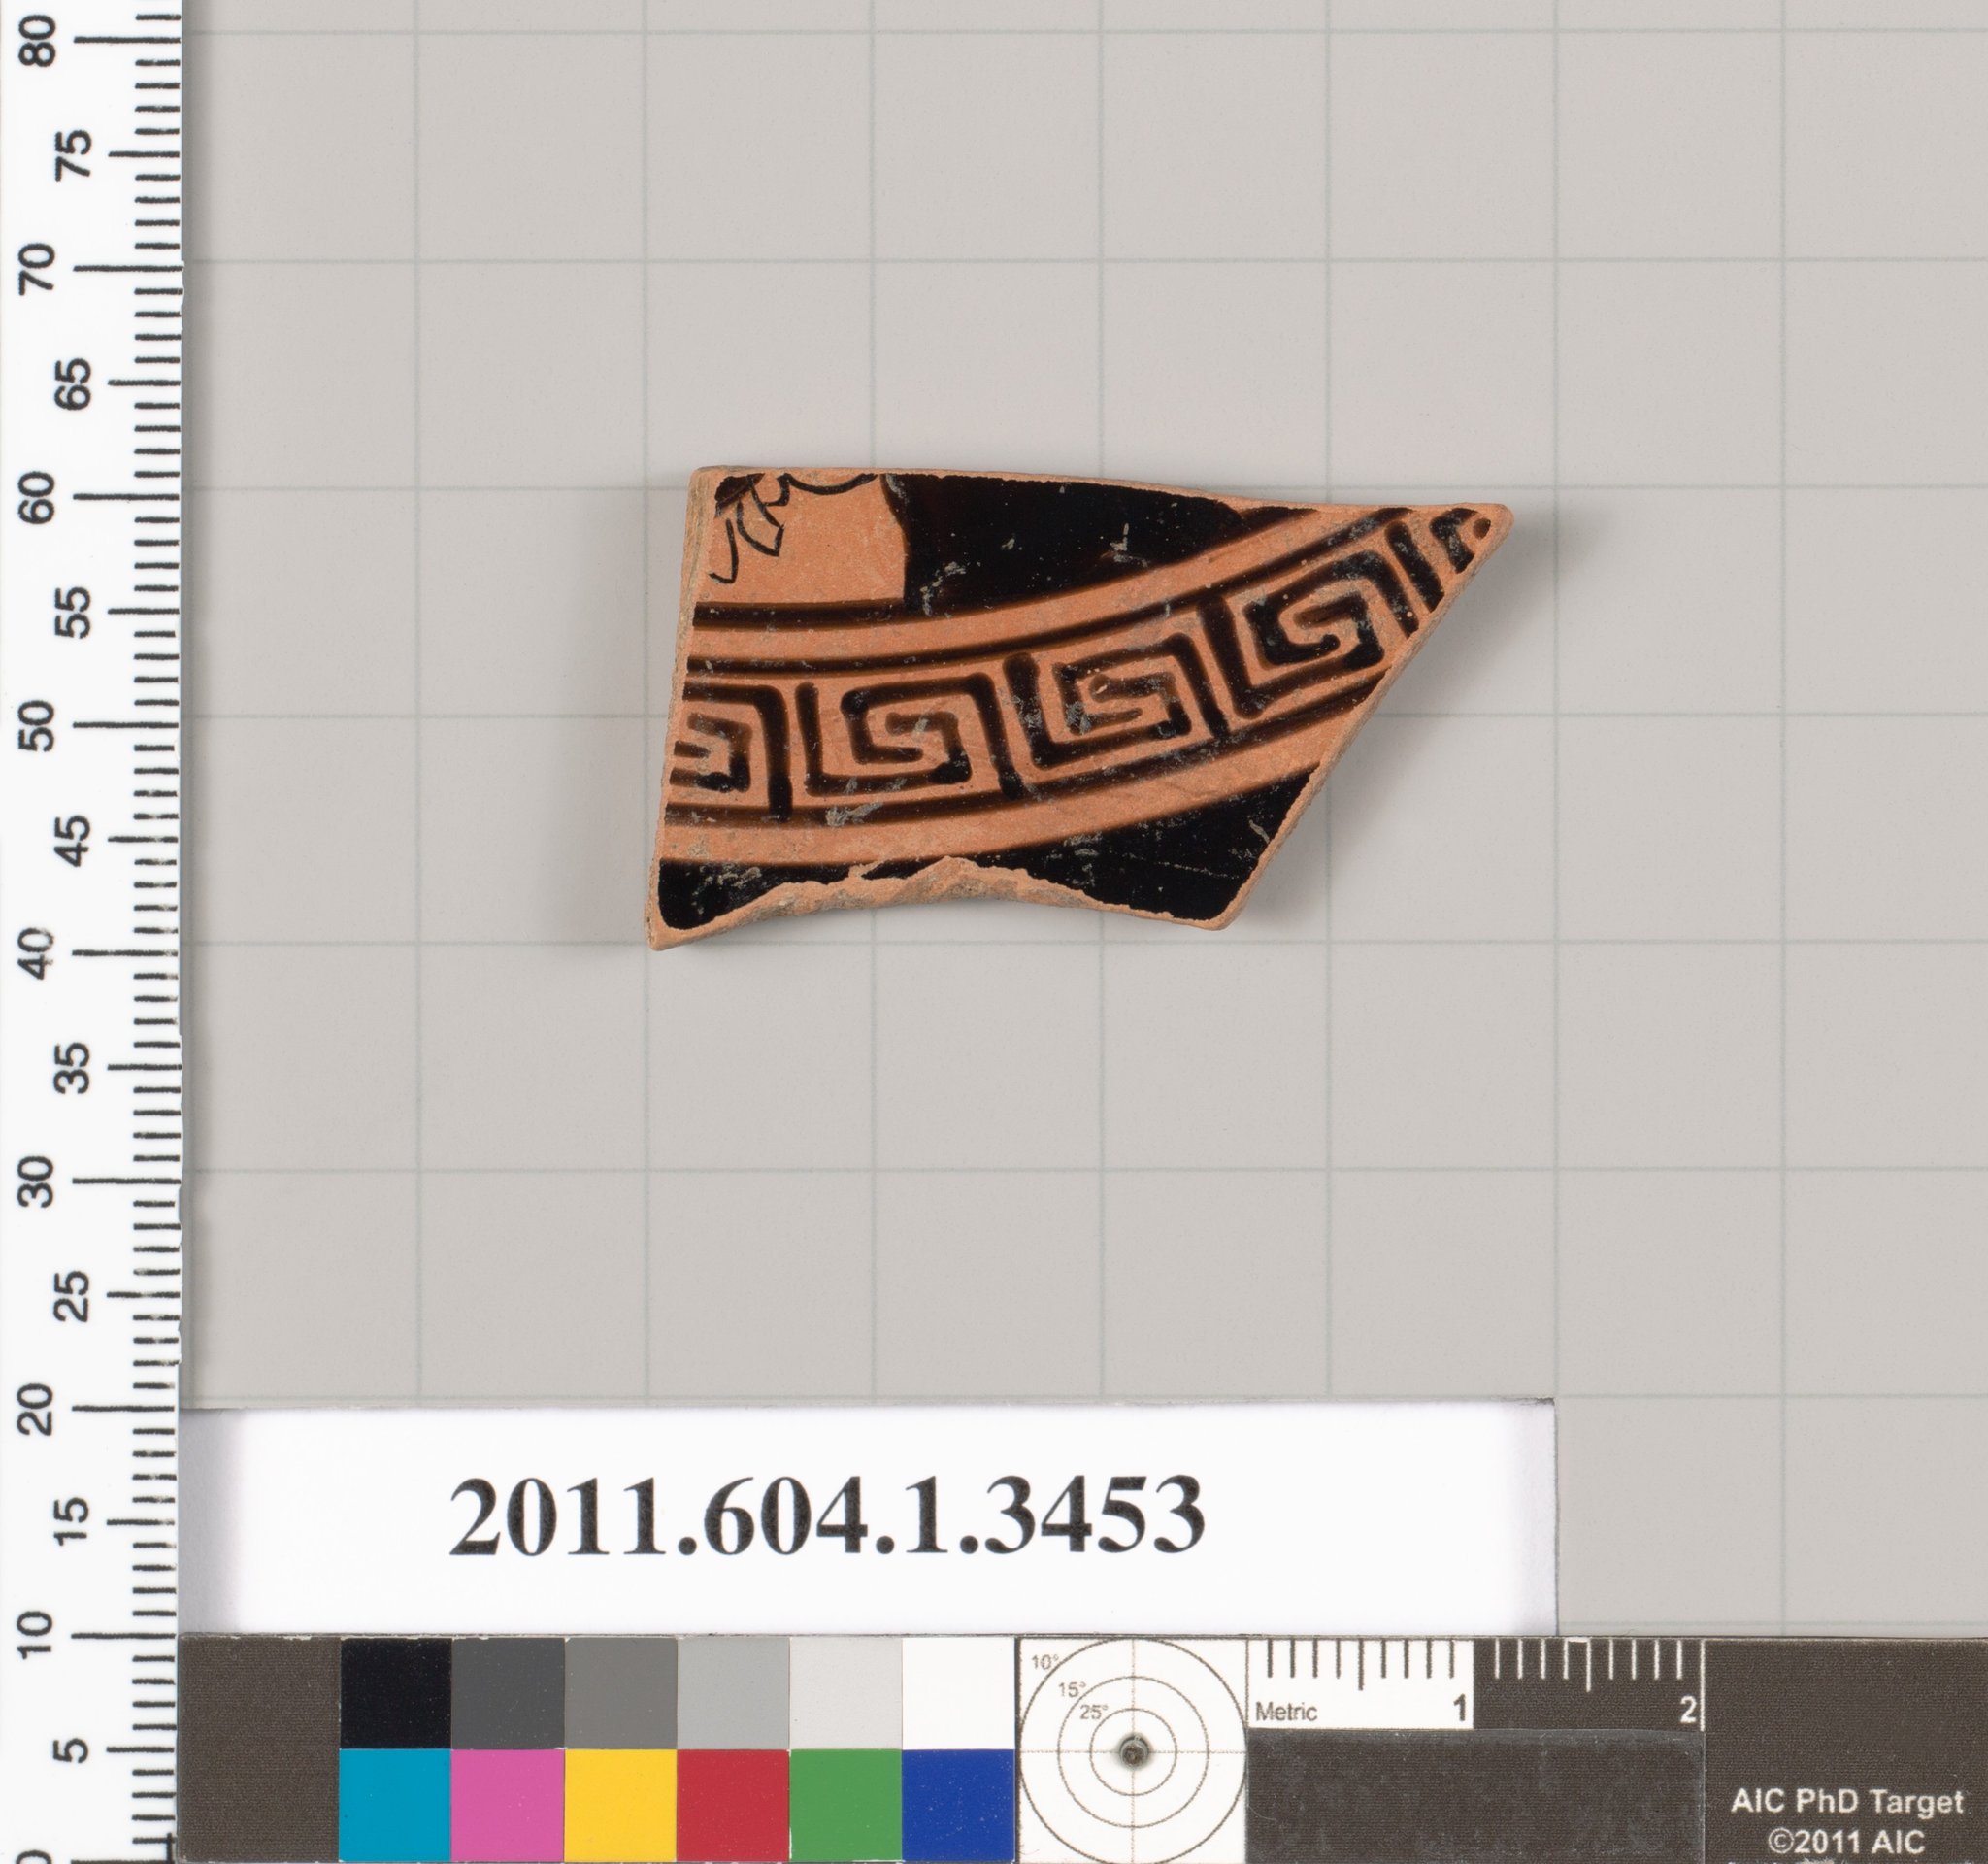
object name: kylix fragment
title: Terracotta fragment of a kylix (drinking cup)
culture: greek, attic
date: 500-476 BCE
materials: terracotta